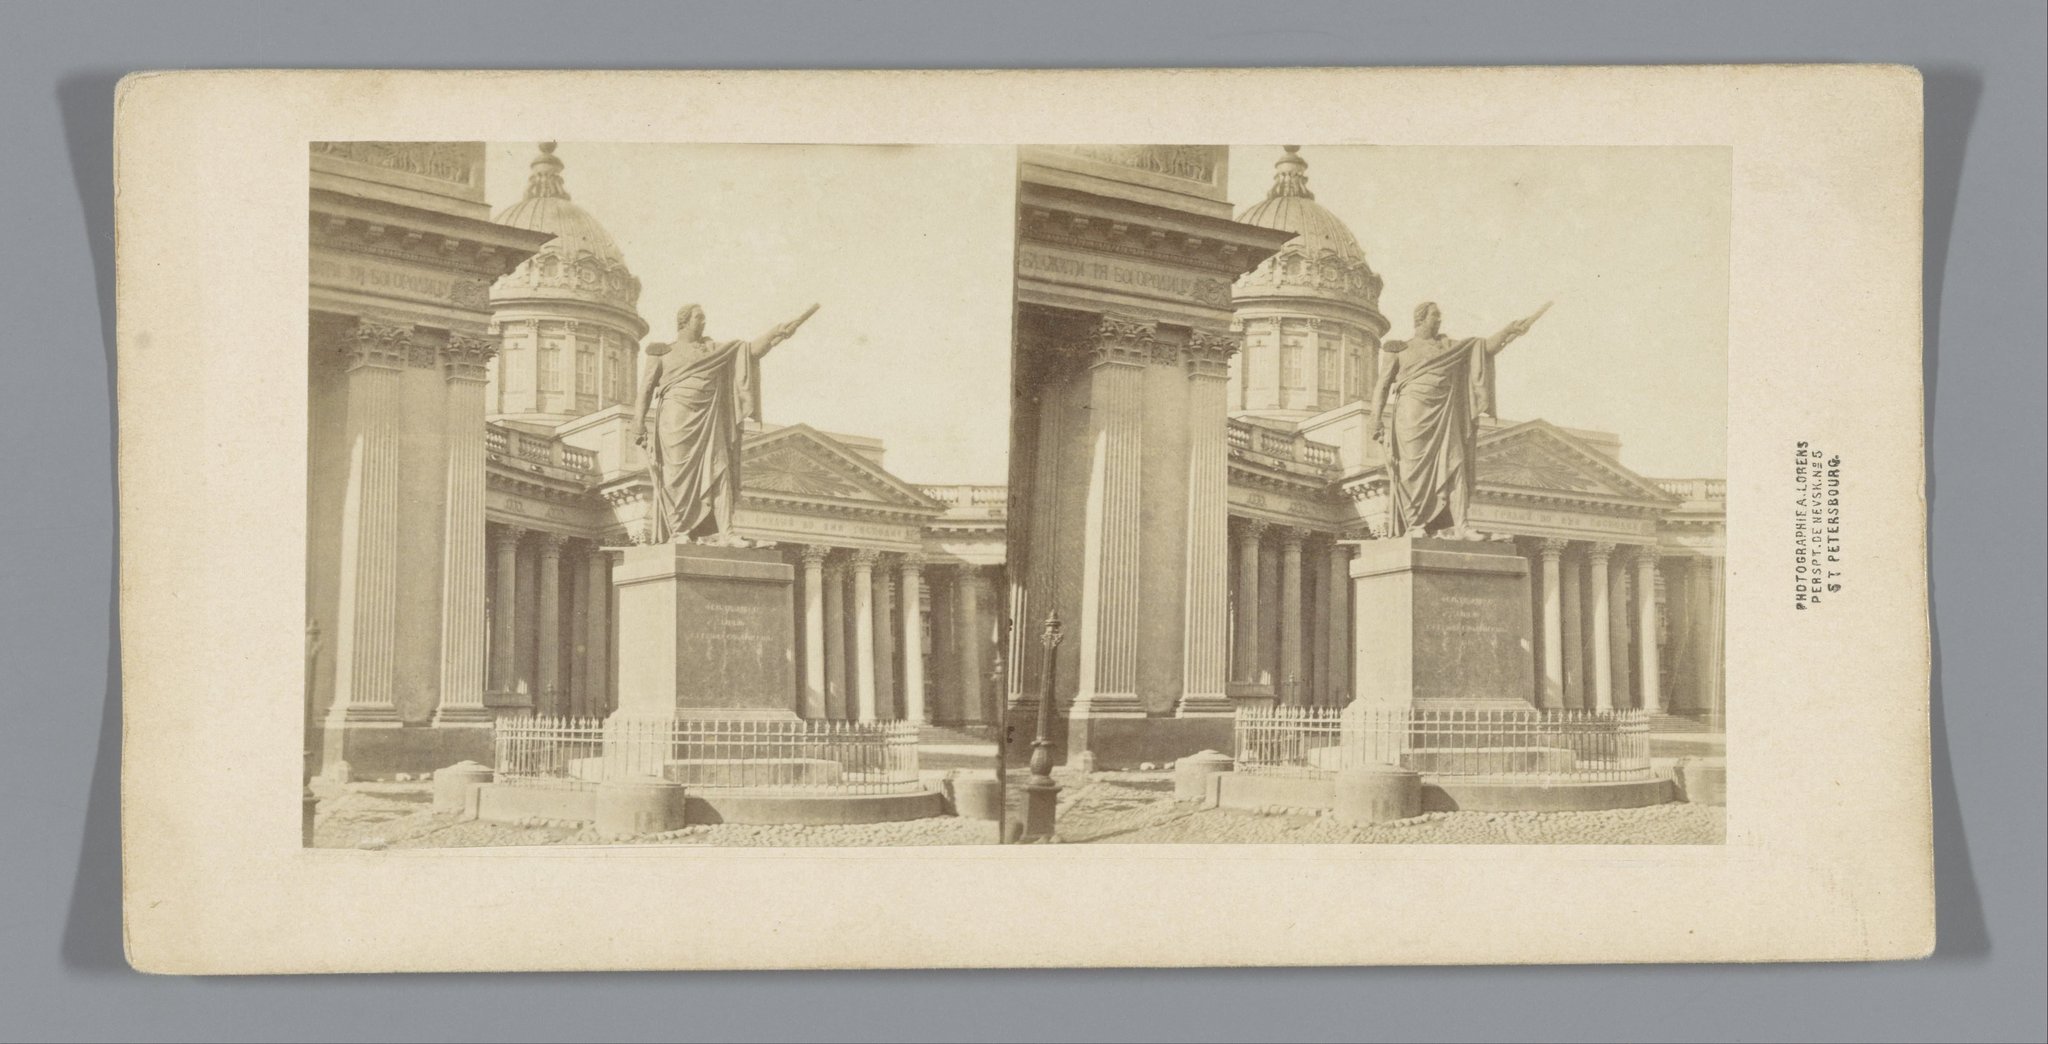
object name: stereograph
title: Gezicht op de Kazankathedraal in Sint-Petersburg met een monument voor veldmaarschalk Michail Koetoezov ervoor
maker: alfred lorens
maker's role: fotograaf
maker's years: 1830-1896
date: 1860-1880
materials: cardboard, photographic support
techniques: albumen print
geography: sint-petersburg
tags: church (exterior), monument, statue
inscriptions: inscription: ‘St. Petersburg, Kasanskerk en beeld [....]’, name: ‘PHOTOGRAPHIE A.LORENS PERSPT.DE NEVSK. NO 5 ST PETERSBOURG.’, number: ‘6. 5.’